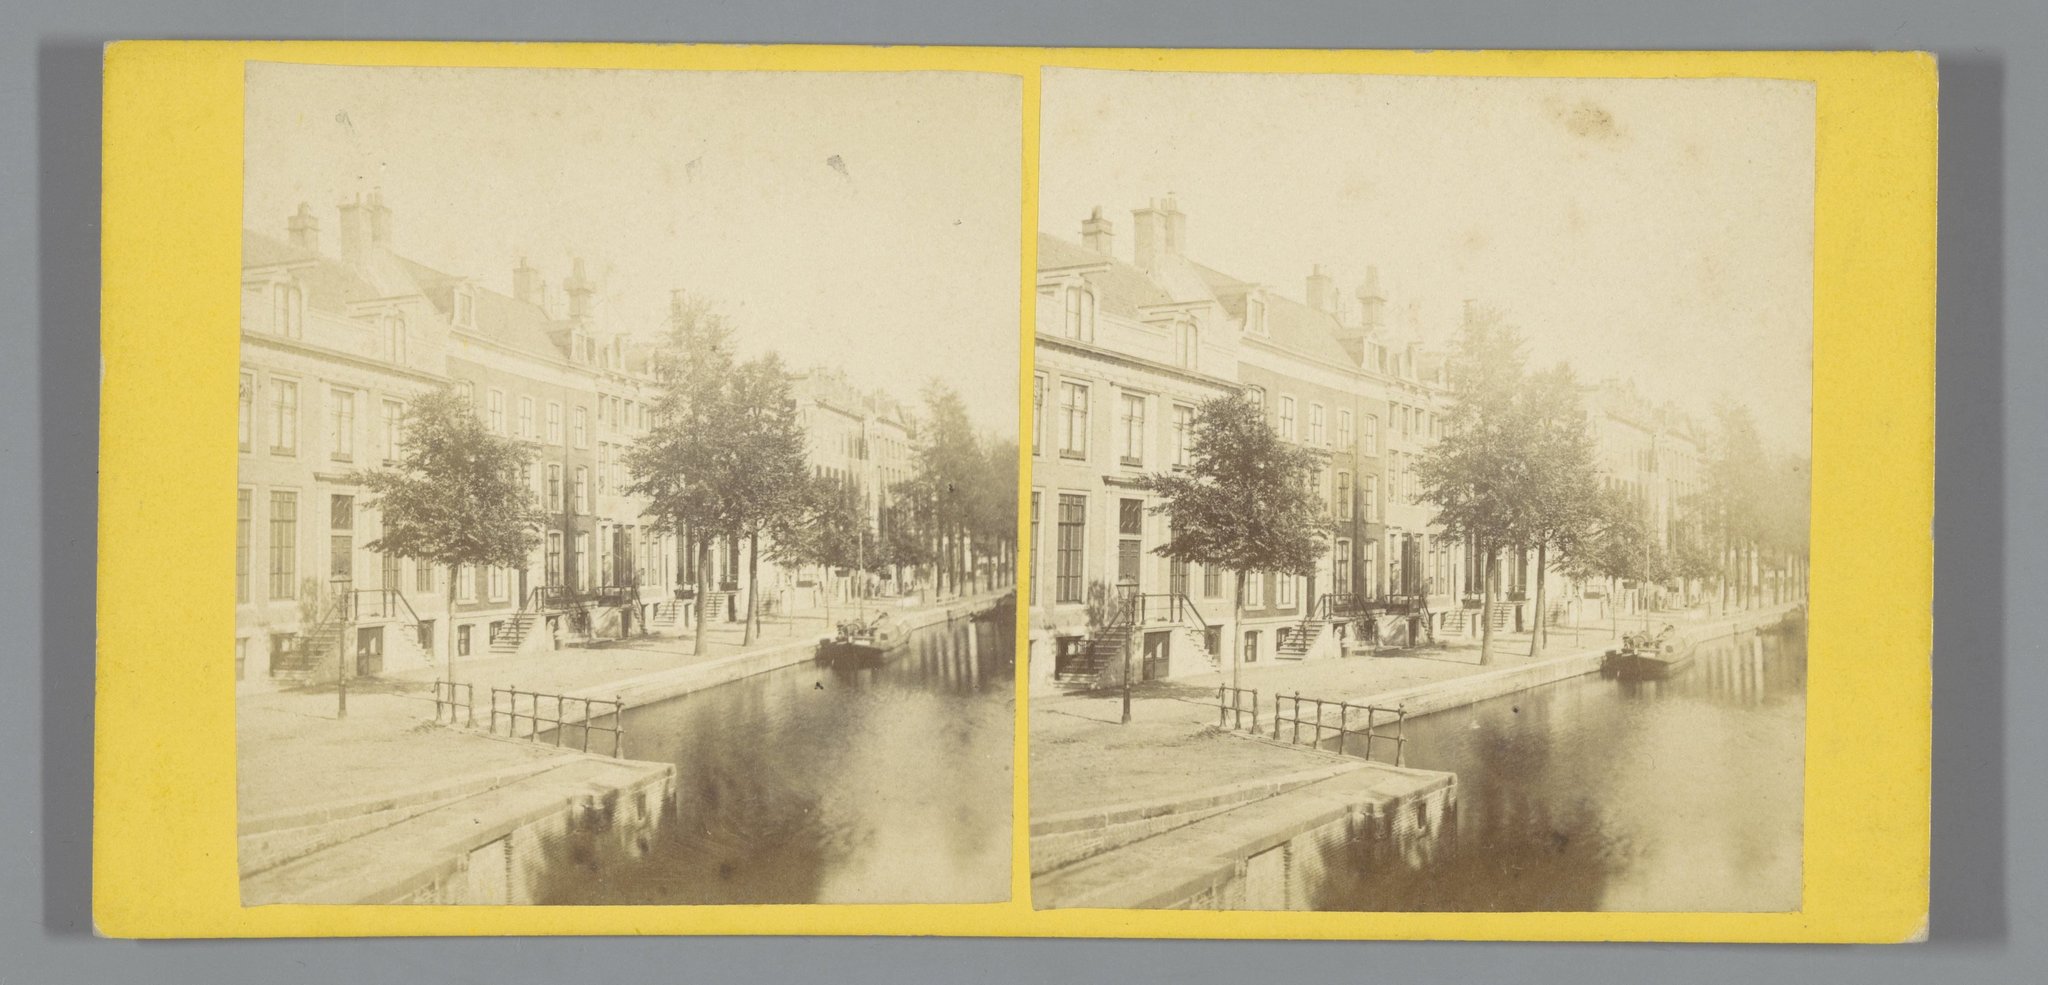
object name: stereograph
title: Gezicht op de Herengracht bij de Muiderstraat in Amsterdam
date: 1860-1885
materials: cardboard, photographic support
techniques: albumen print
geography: amsterdam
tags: canals, waters (in city), street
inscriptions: number: ‘4.5’, inscription: ‘Uitgegeven bij A. JAGER, Water 110, te Amsterdam.’, annotation: ‘Heerengracht nabij Amstel bij/ Muiderstraat’